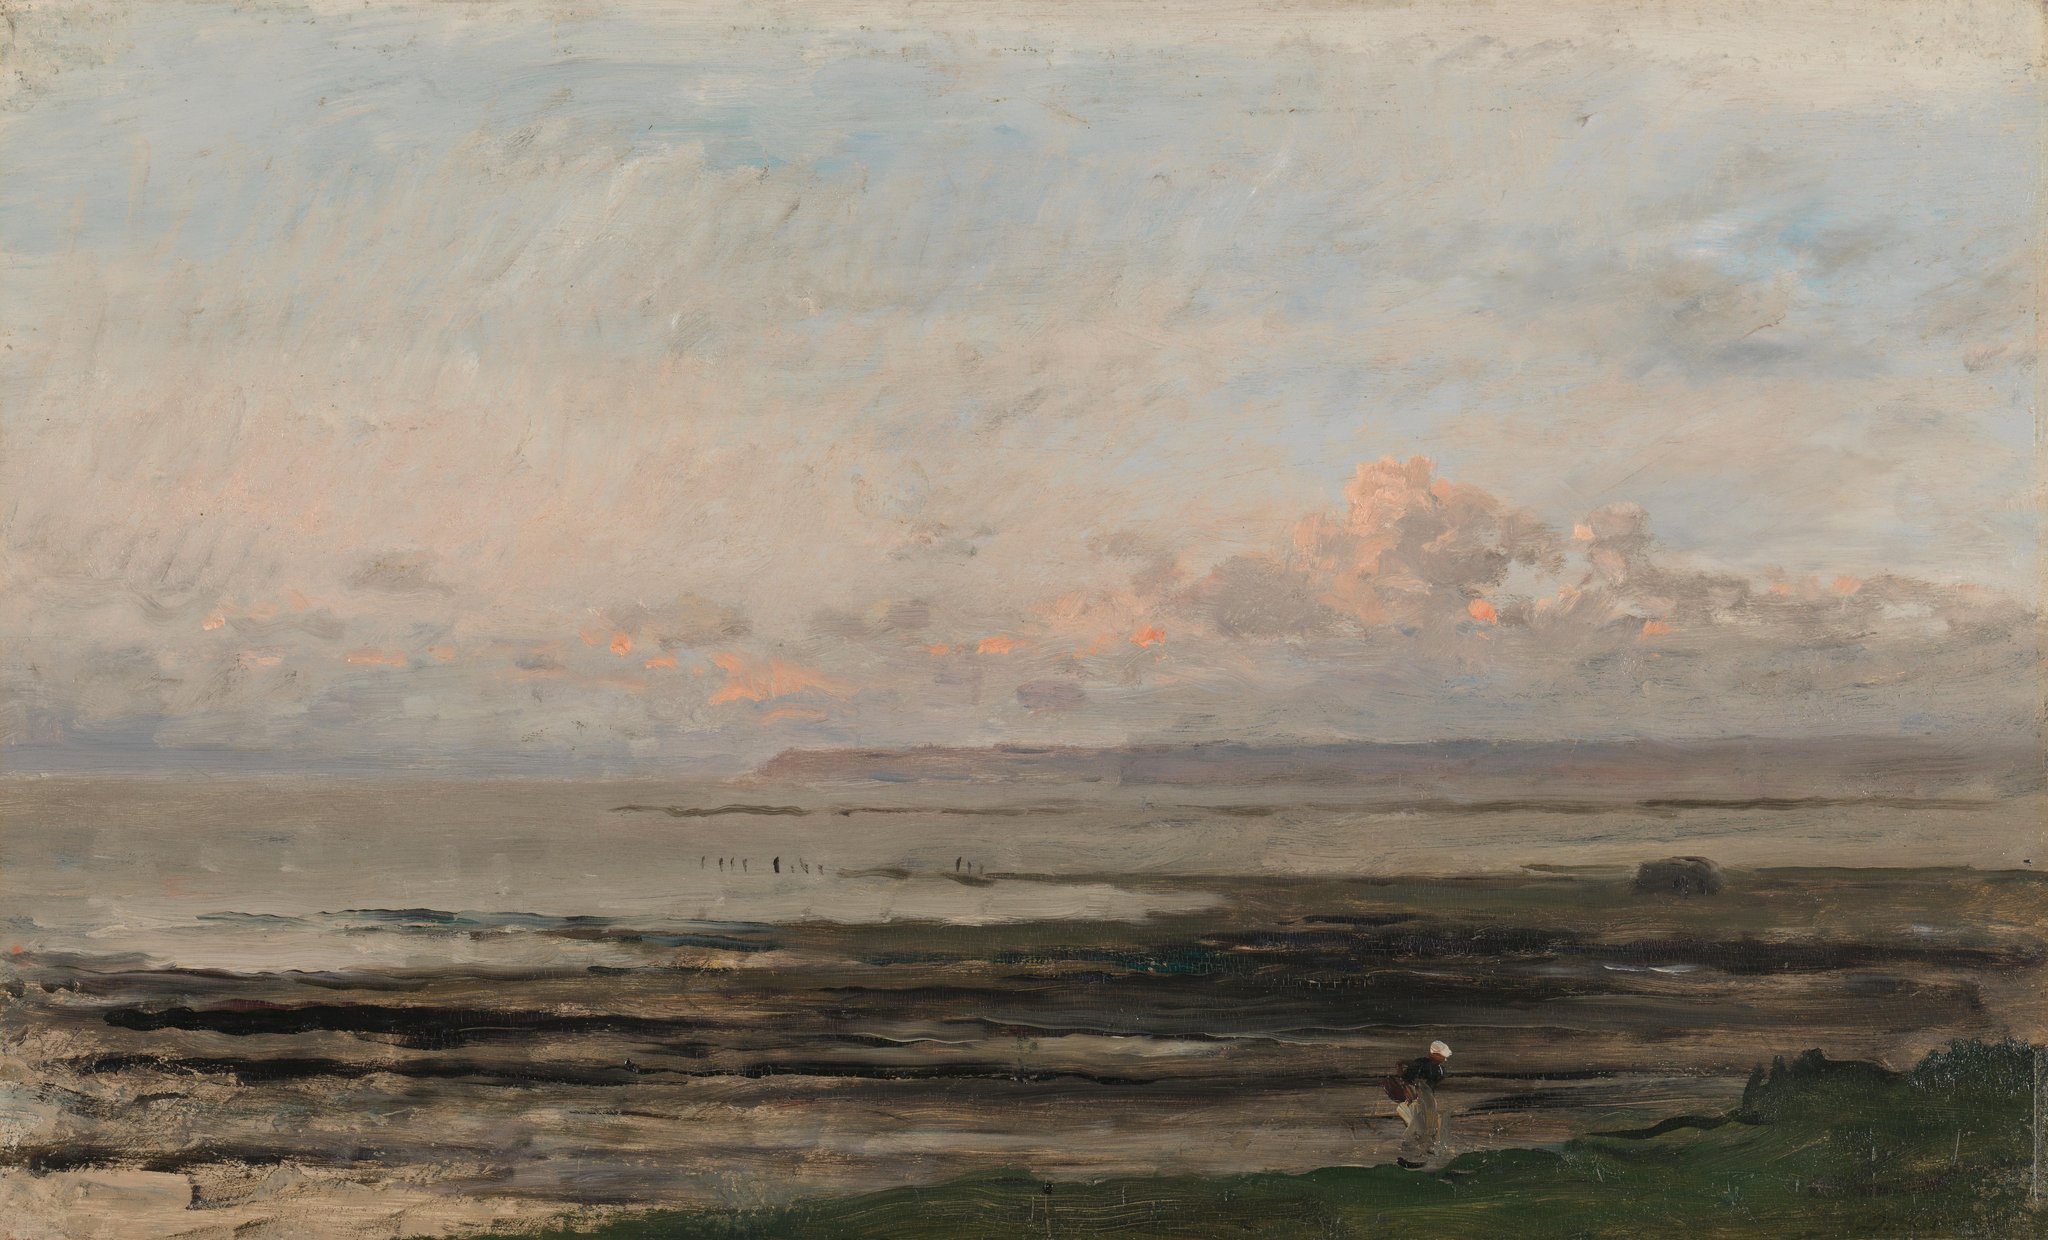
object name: painting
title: A Beach at Ebb Tide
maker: charles-françois daubigny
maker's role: draughtsman, painter, print maker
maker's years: 1817-1878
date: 1850-1878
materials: oil, panel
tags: beach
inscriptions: signature: ‘Daubigny’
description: Daubigny painted this beautiful seascape in Villerville-sur-Mer in Normandy. On an otherwise empty beach, a lone shell seeker walks along, with a basket on her back. Hague School painters greatly admired Daubigny. His broad brushstrokes and subtle colour nuances were ideally suited to depicting the Dutch landscape.